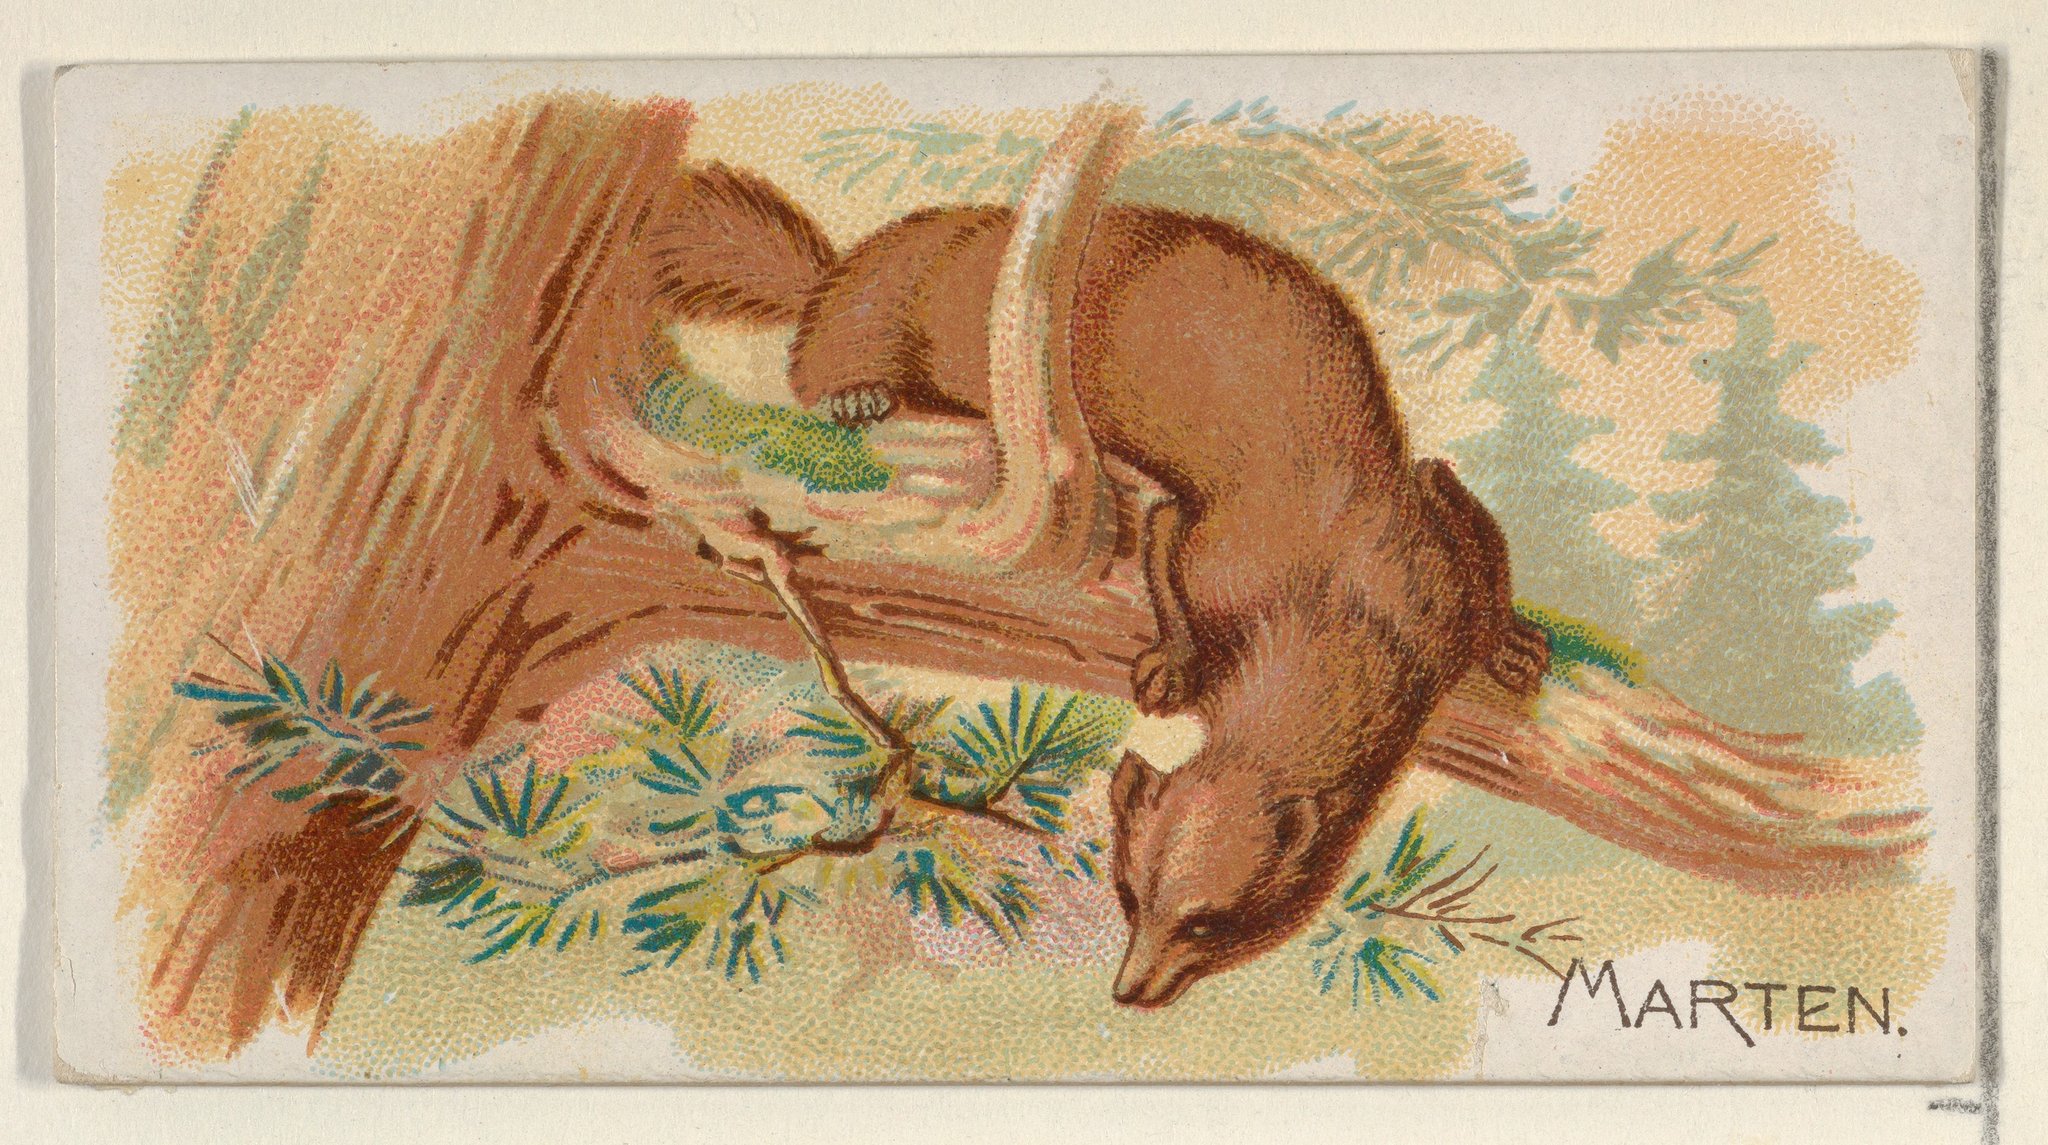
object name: print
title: Marten, from the Quadrupeds series (N21) for Allen & Ginter Cigarettes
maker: allen & ginter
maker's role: publisher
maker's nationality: american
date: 1890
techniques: color lithograph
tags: animals